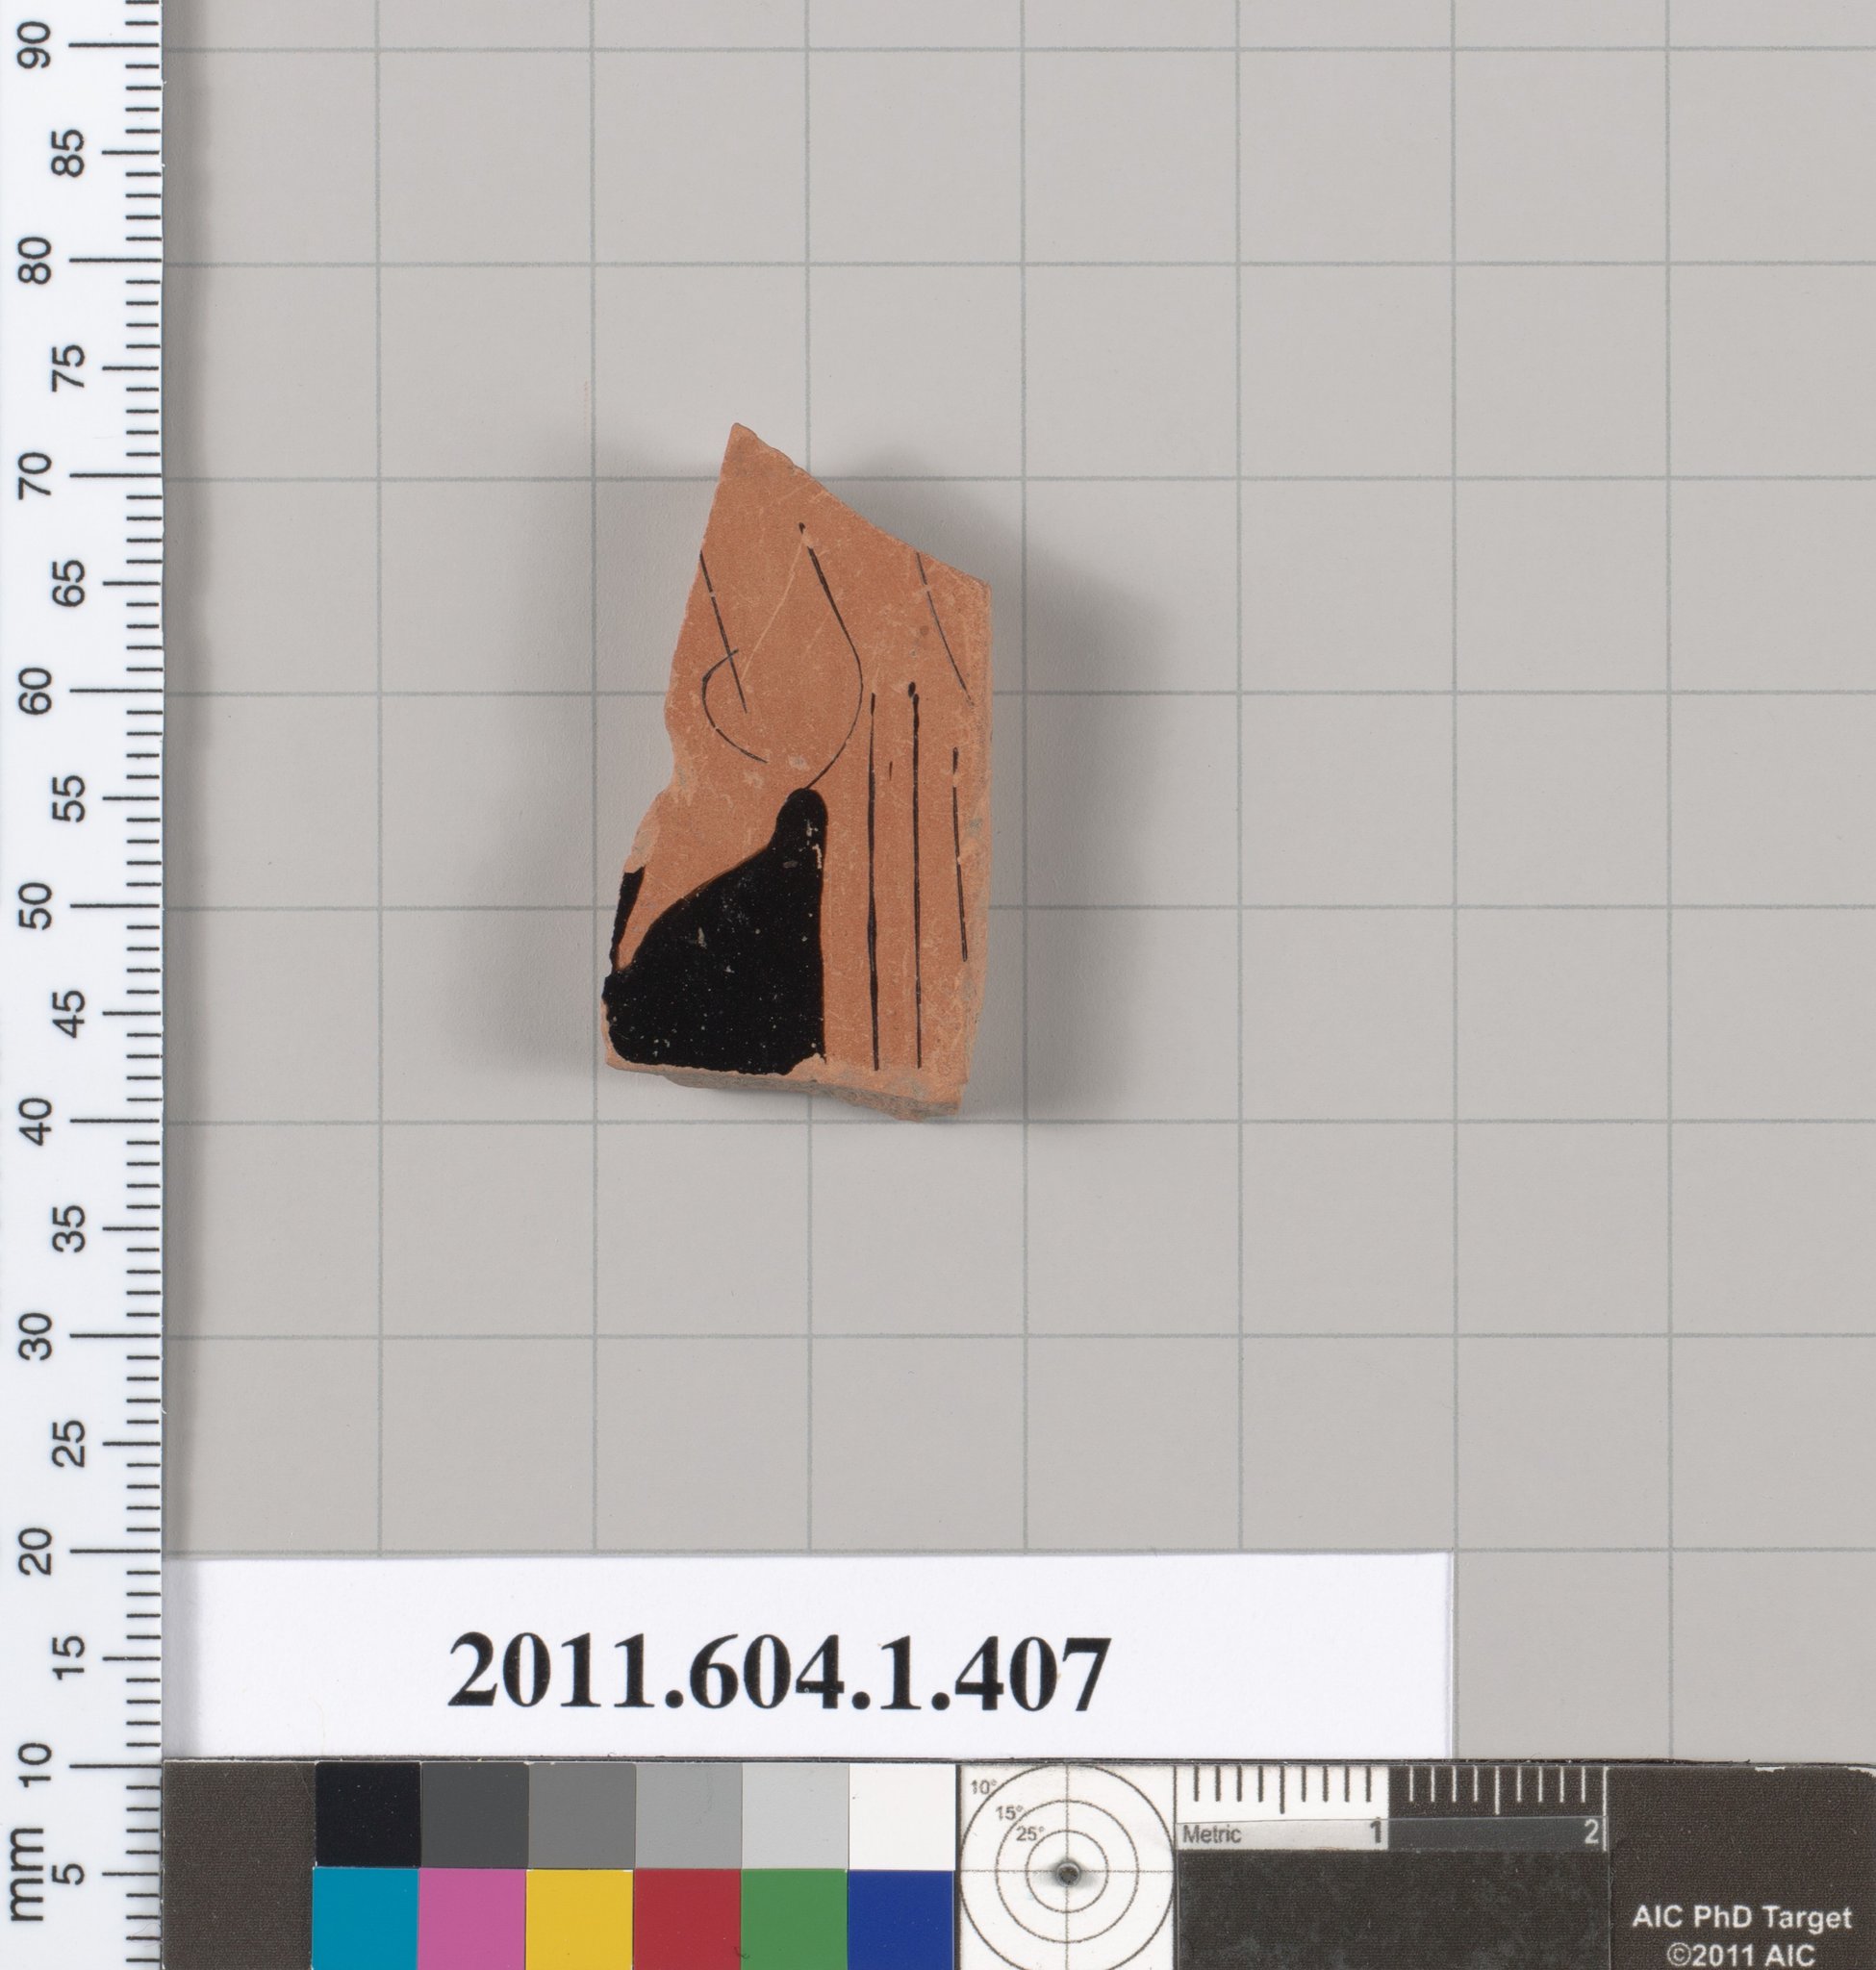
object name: kylix fragment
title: Terracotta fragment of a kylix (drinking cup)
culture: greek, attic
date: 475-451 BCE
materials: terracotta